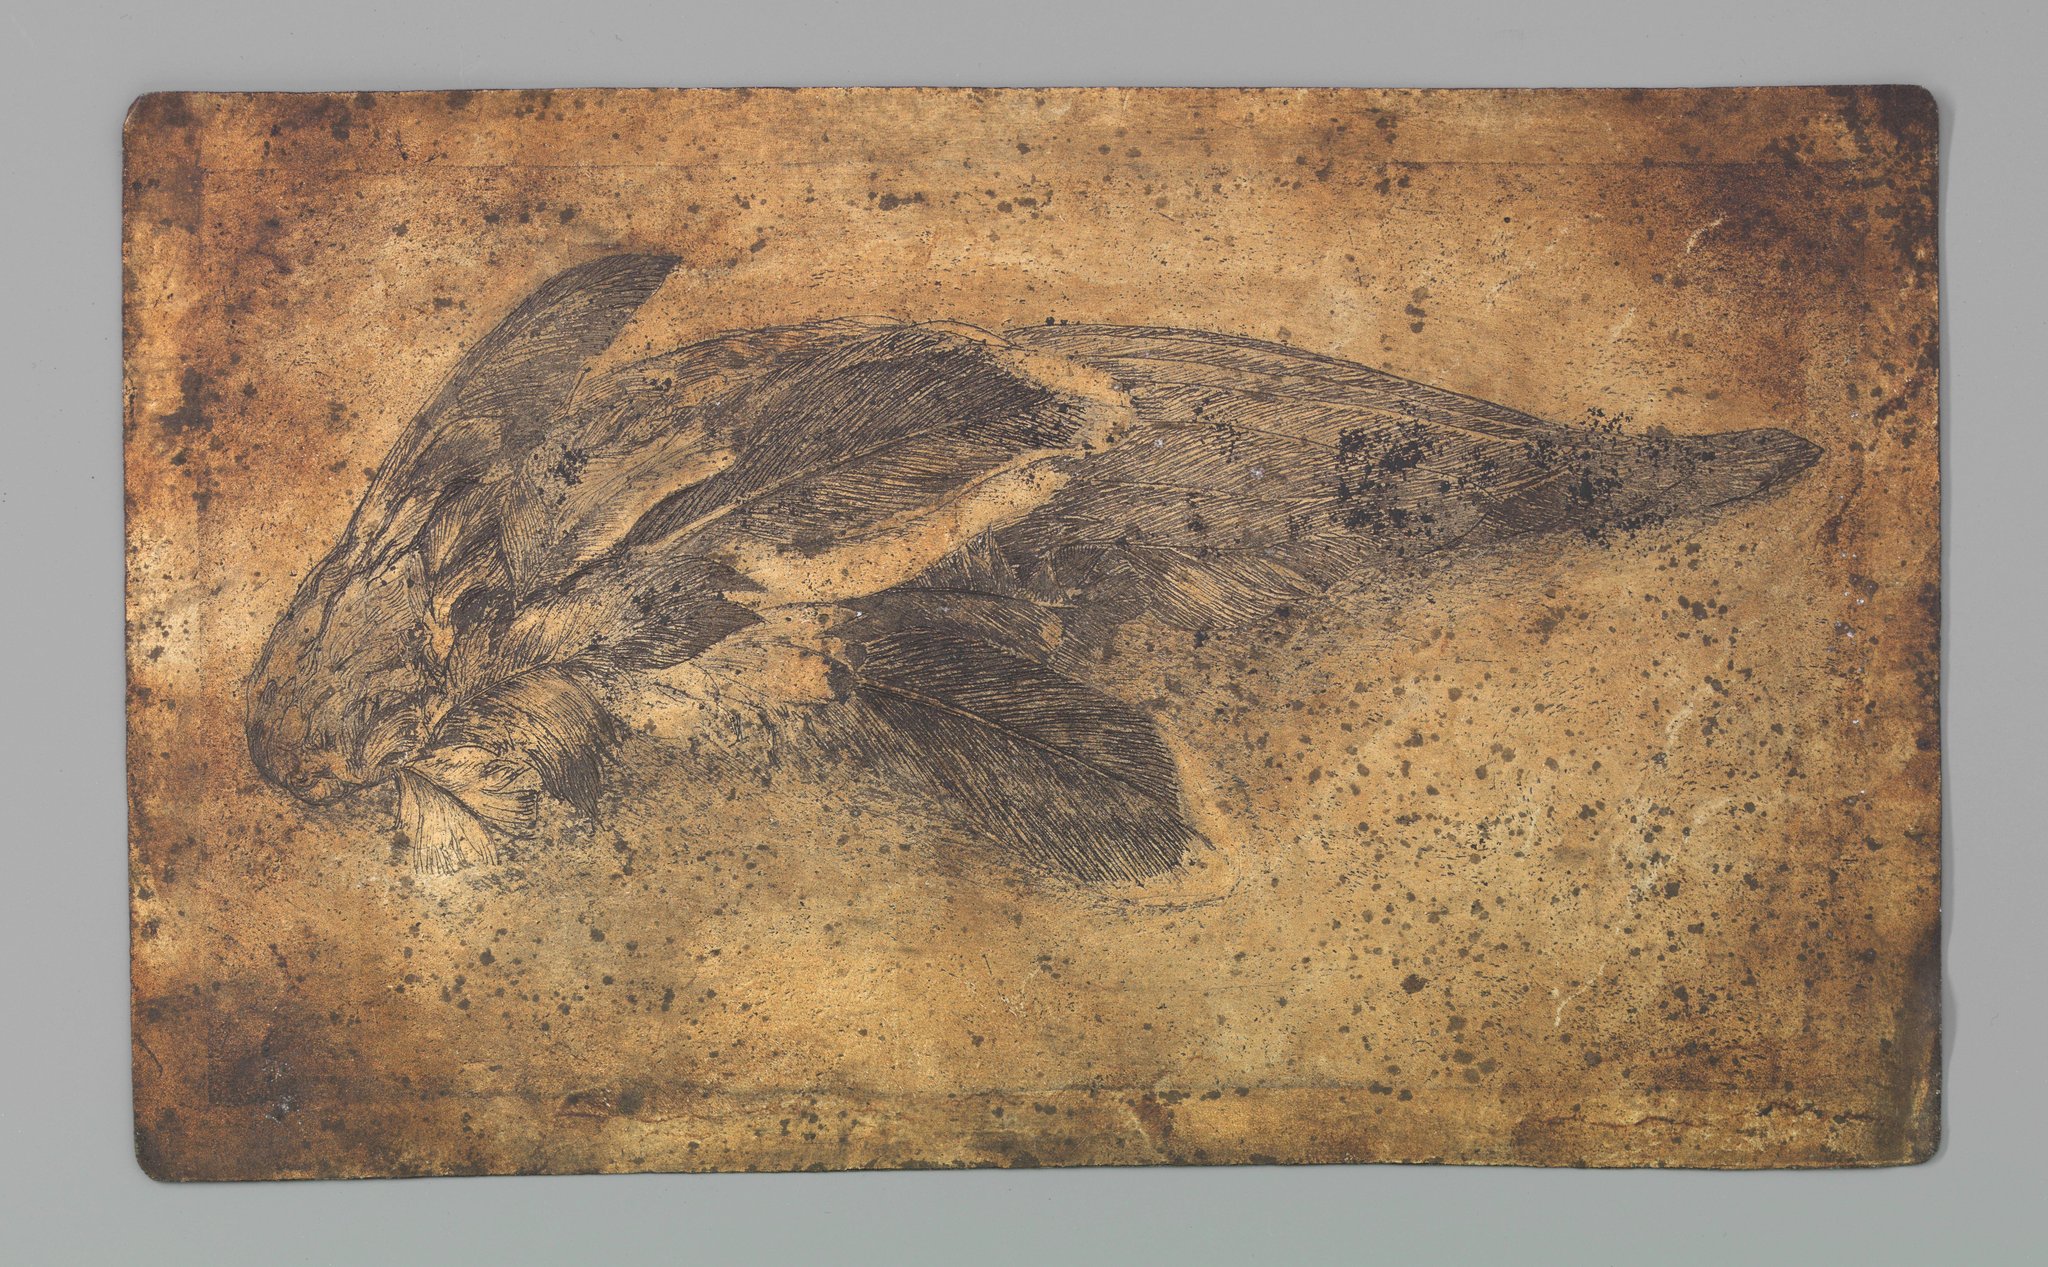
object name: messingplaat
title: Gevederde vleugel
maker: jan petrus ponstijn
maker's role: draughtsman, print maker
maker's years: 1883-1970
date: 1948-1949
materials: brass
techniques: aquatint, etching